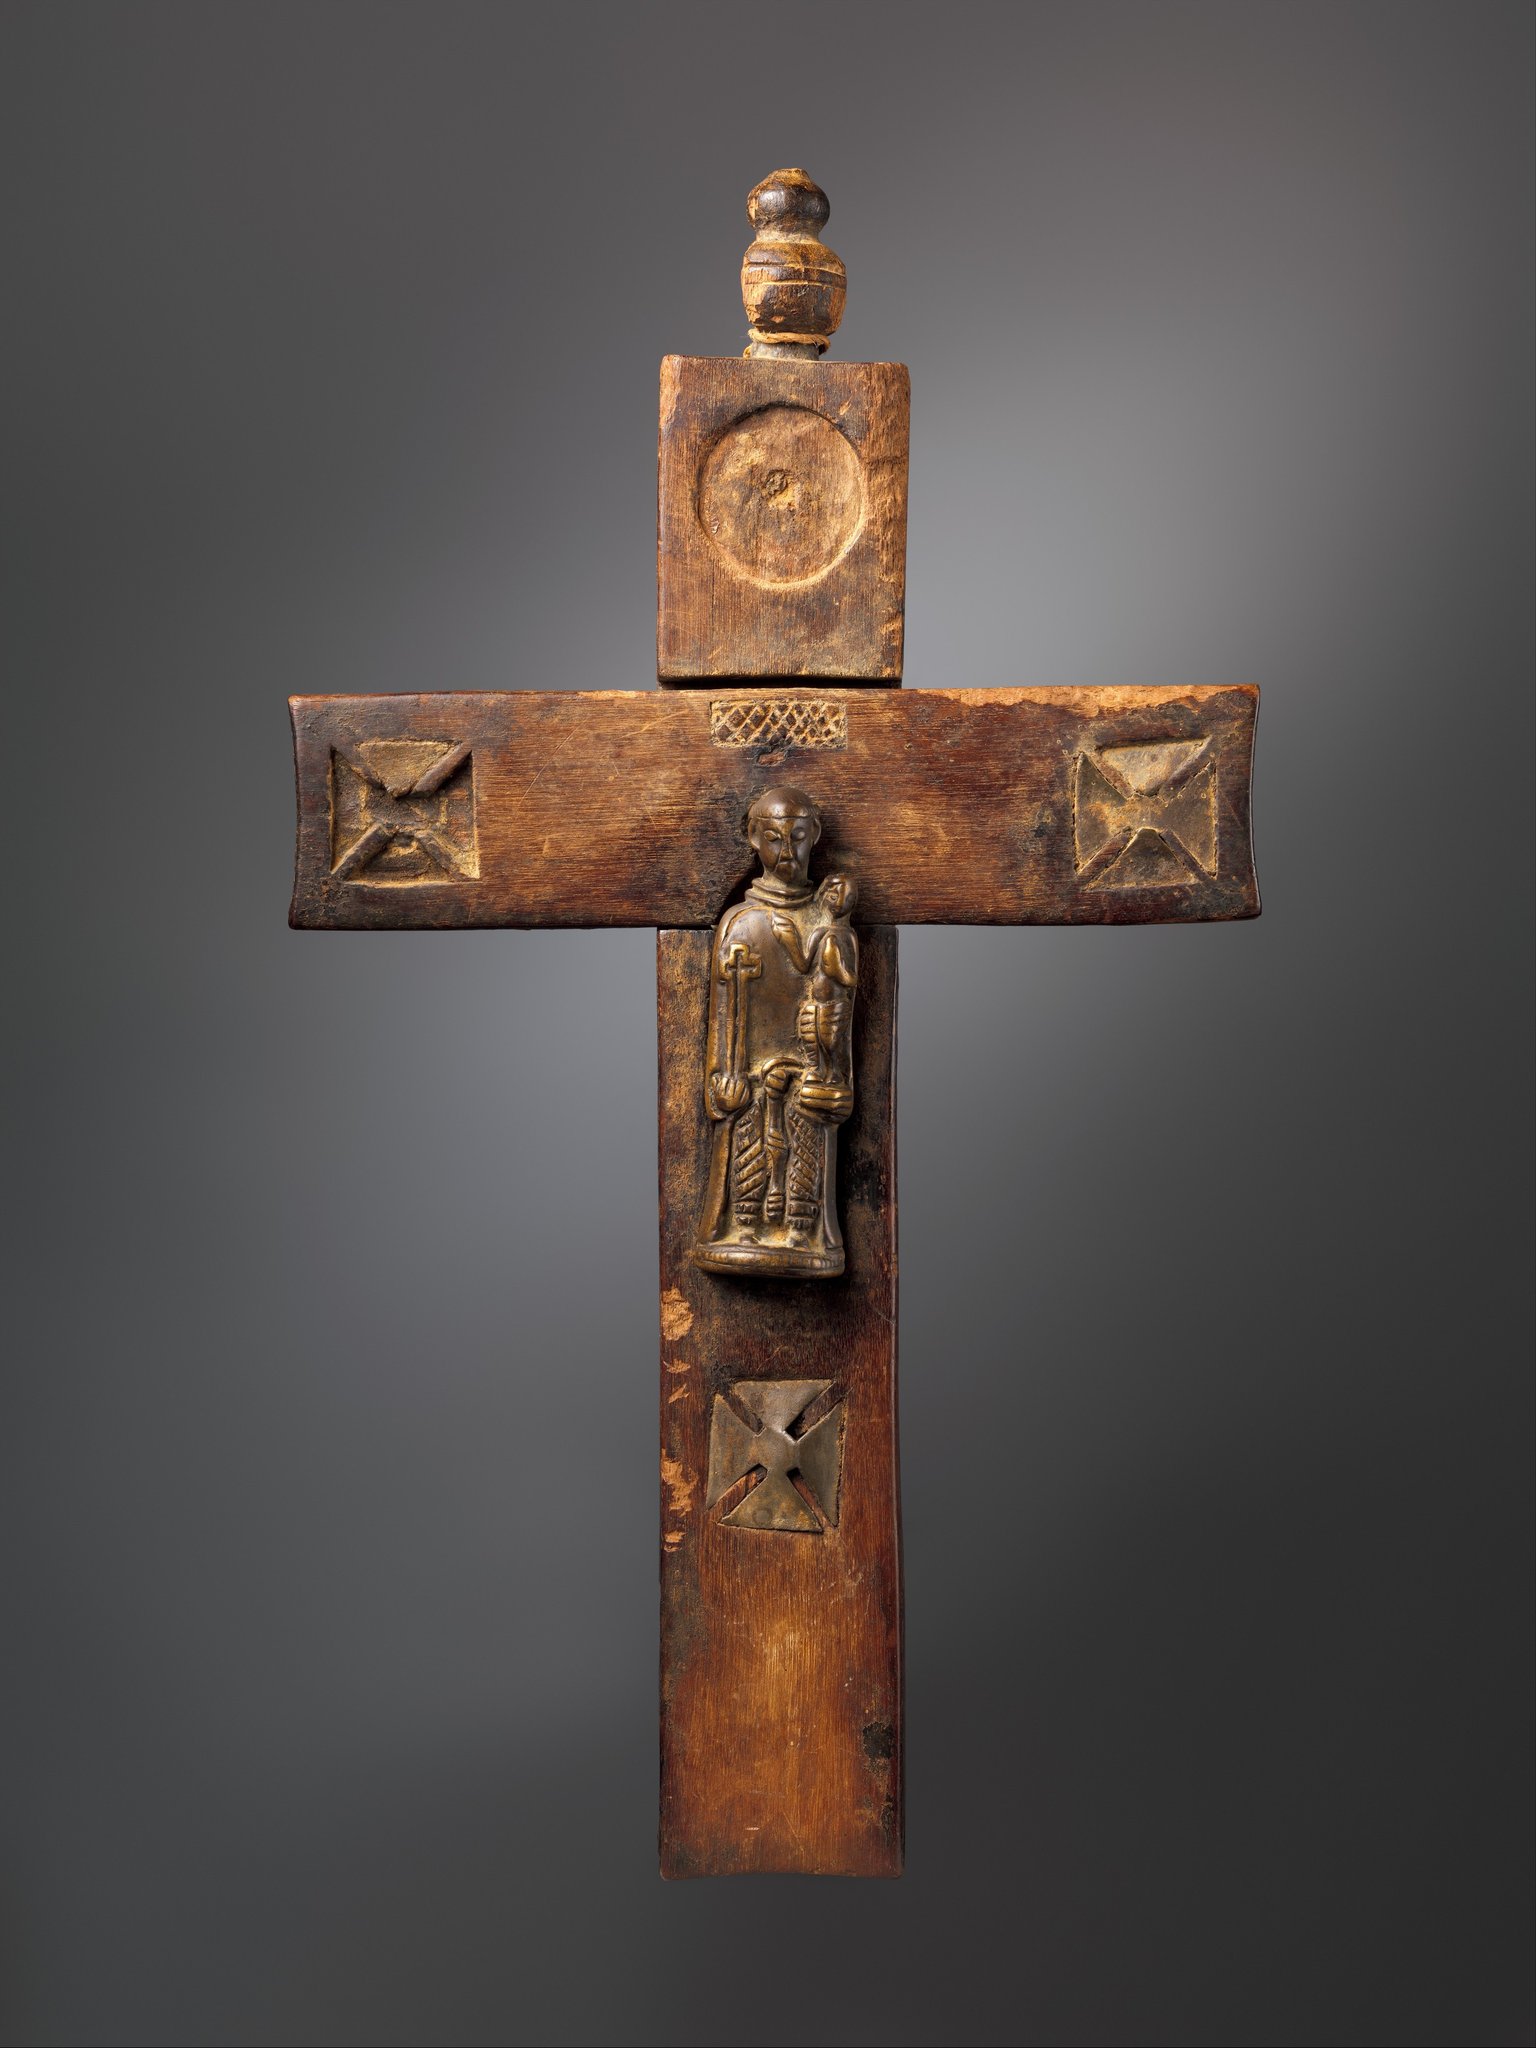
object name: cross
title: Crucifix with Saint Anthony of Padua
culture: kongo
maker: kongo artist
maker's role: artist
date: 1501-1800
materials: alloy, brass, cord, fiber, lead, tin, wood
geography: angola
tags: men,christ,saint anthony,cross